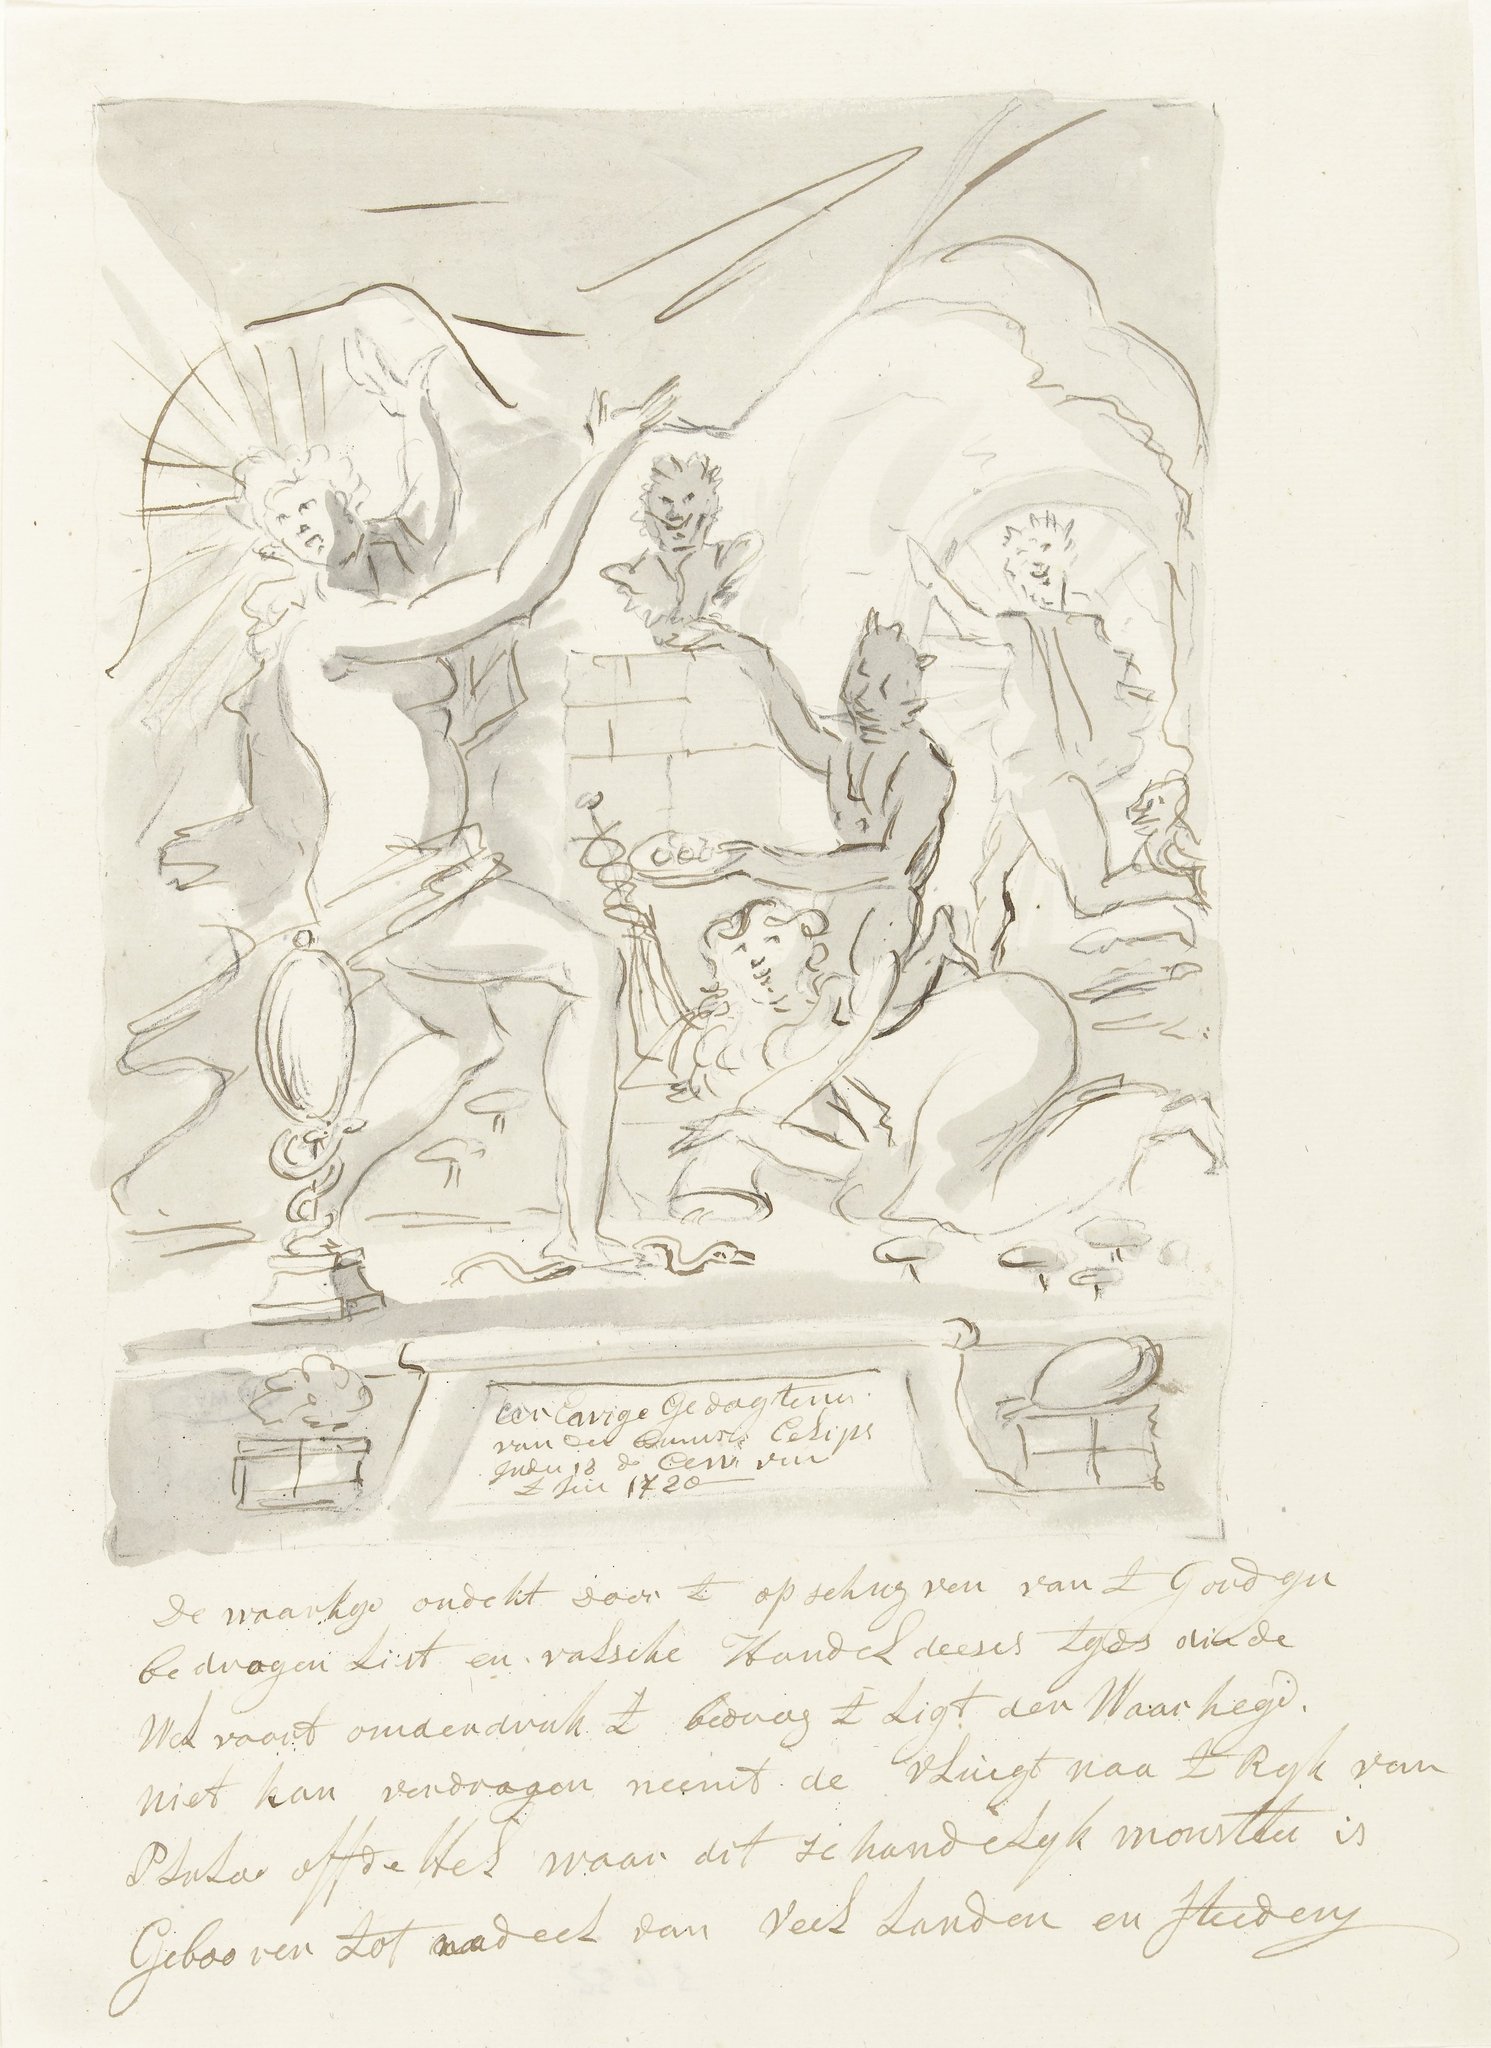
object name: drawing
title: Waarheid onthult het bedrog van de windhandel van 1720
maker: Anonymous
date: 1720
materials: paper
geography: northern netherlands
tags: truth; 'verità' (ripa)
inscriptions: collector's mark: Lugt 2228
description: De Waarheid neemt het gordijn van een altaar en onthult het bedrog van de windhandel van 1720. Met onderschrift van zes regels. Ontwerptekening voor een niet uitgevoerde prent. Behoort tot de groep van tekeningen toegevoegd aan de serie Tafereel der Dwaasheid met spotprenten op de Windhandel of Actiehandel van 1720.